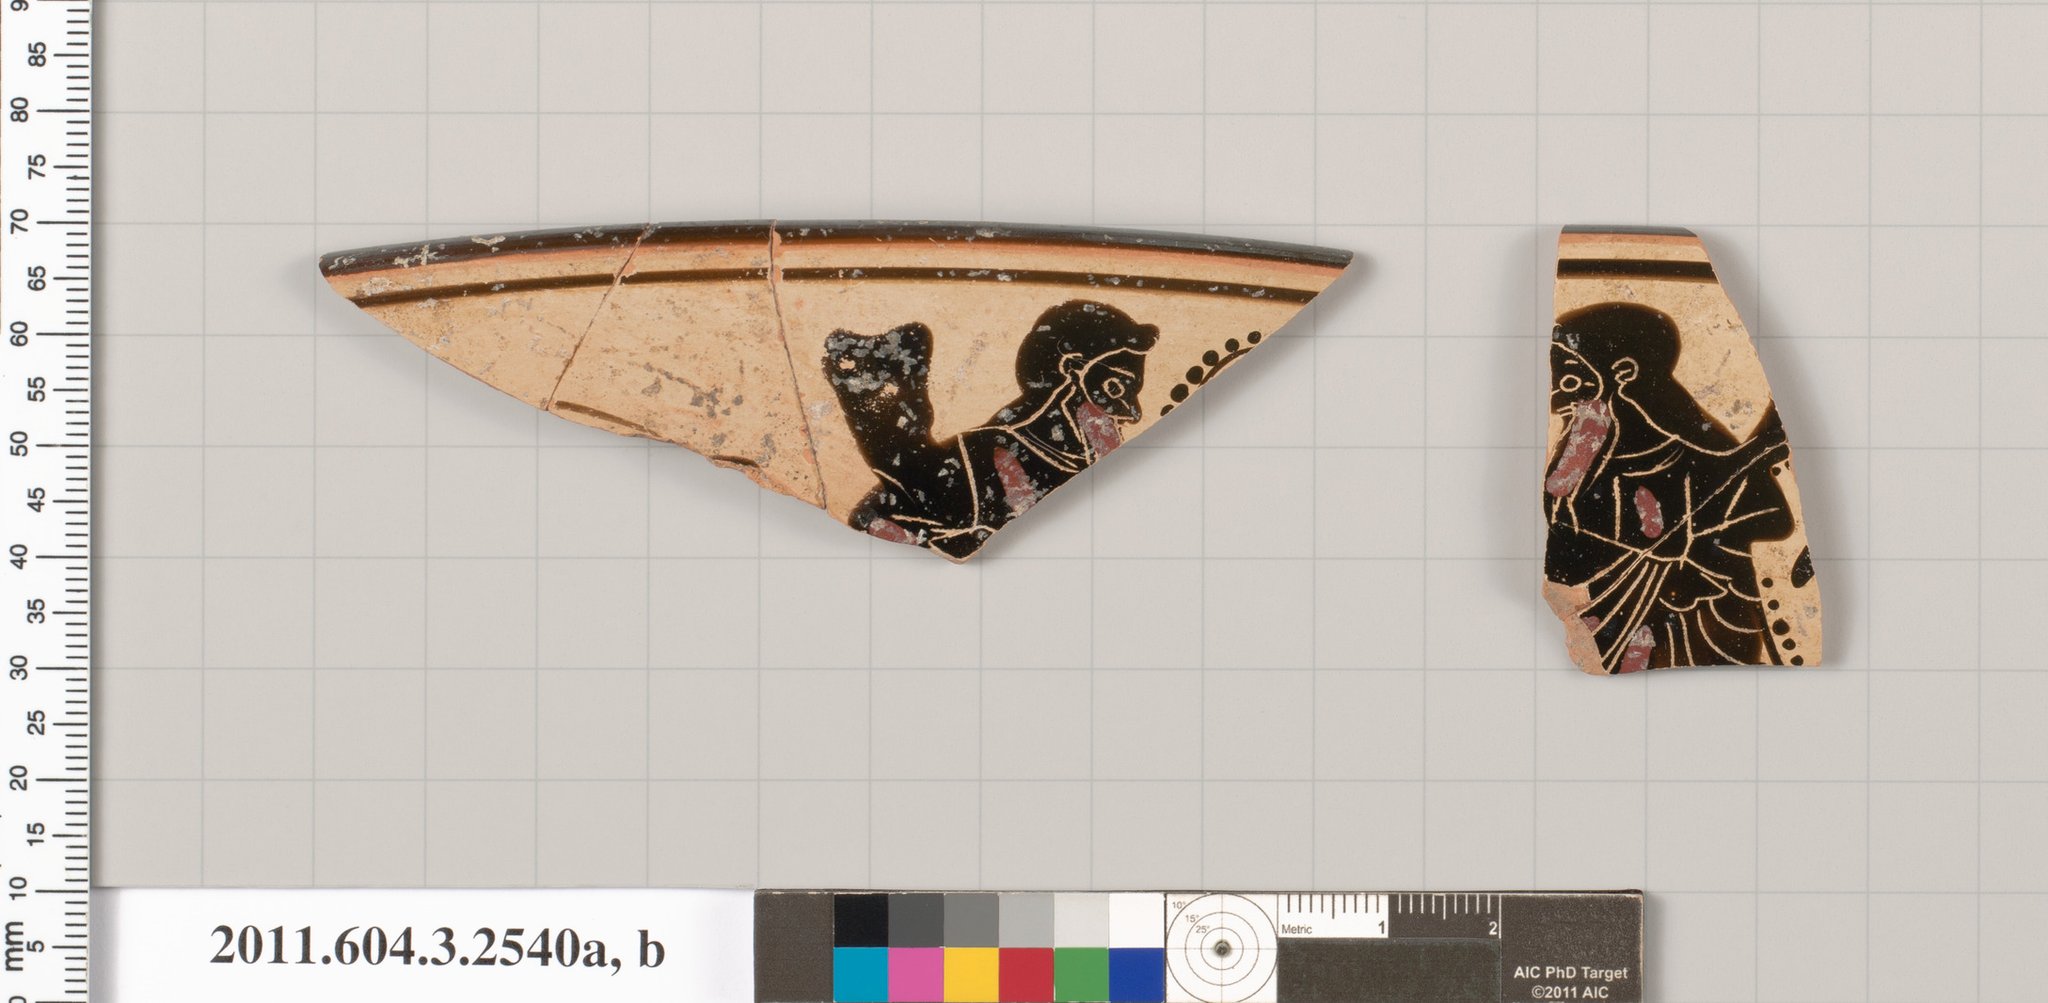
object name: kylix fragment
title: Terracotta rim fragments of a kylix (drinking cup)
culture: greek, attic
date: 534-468 BCE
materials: terracotta